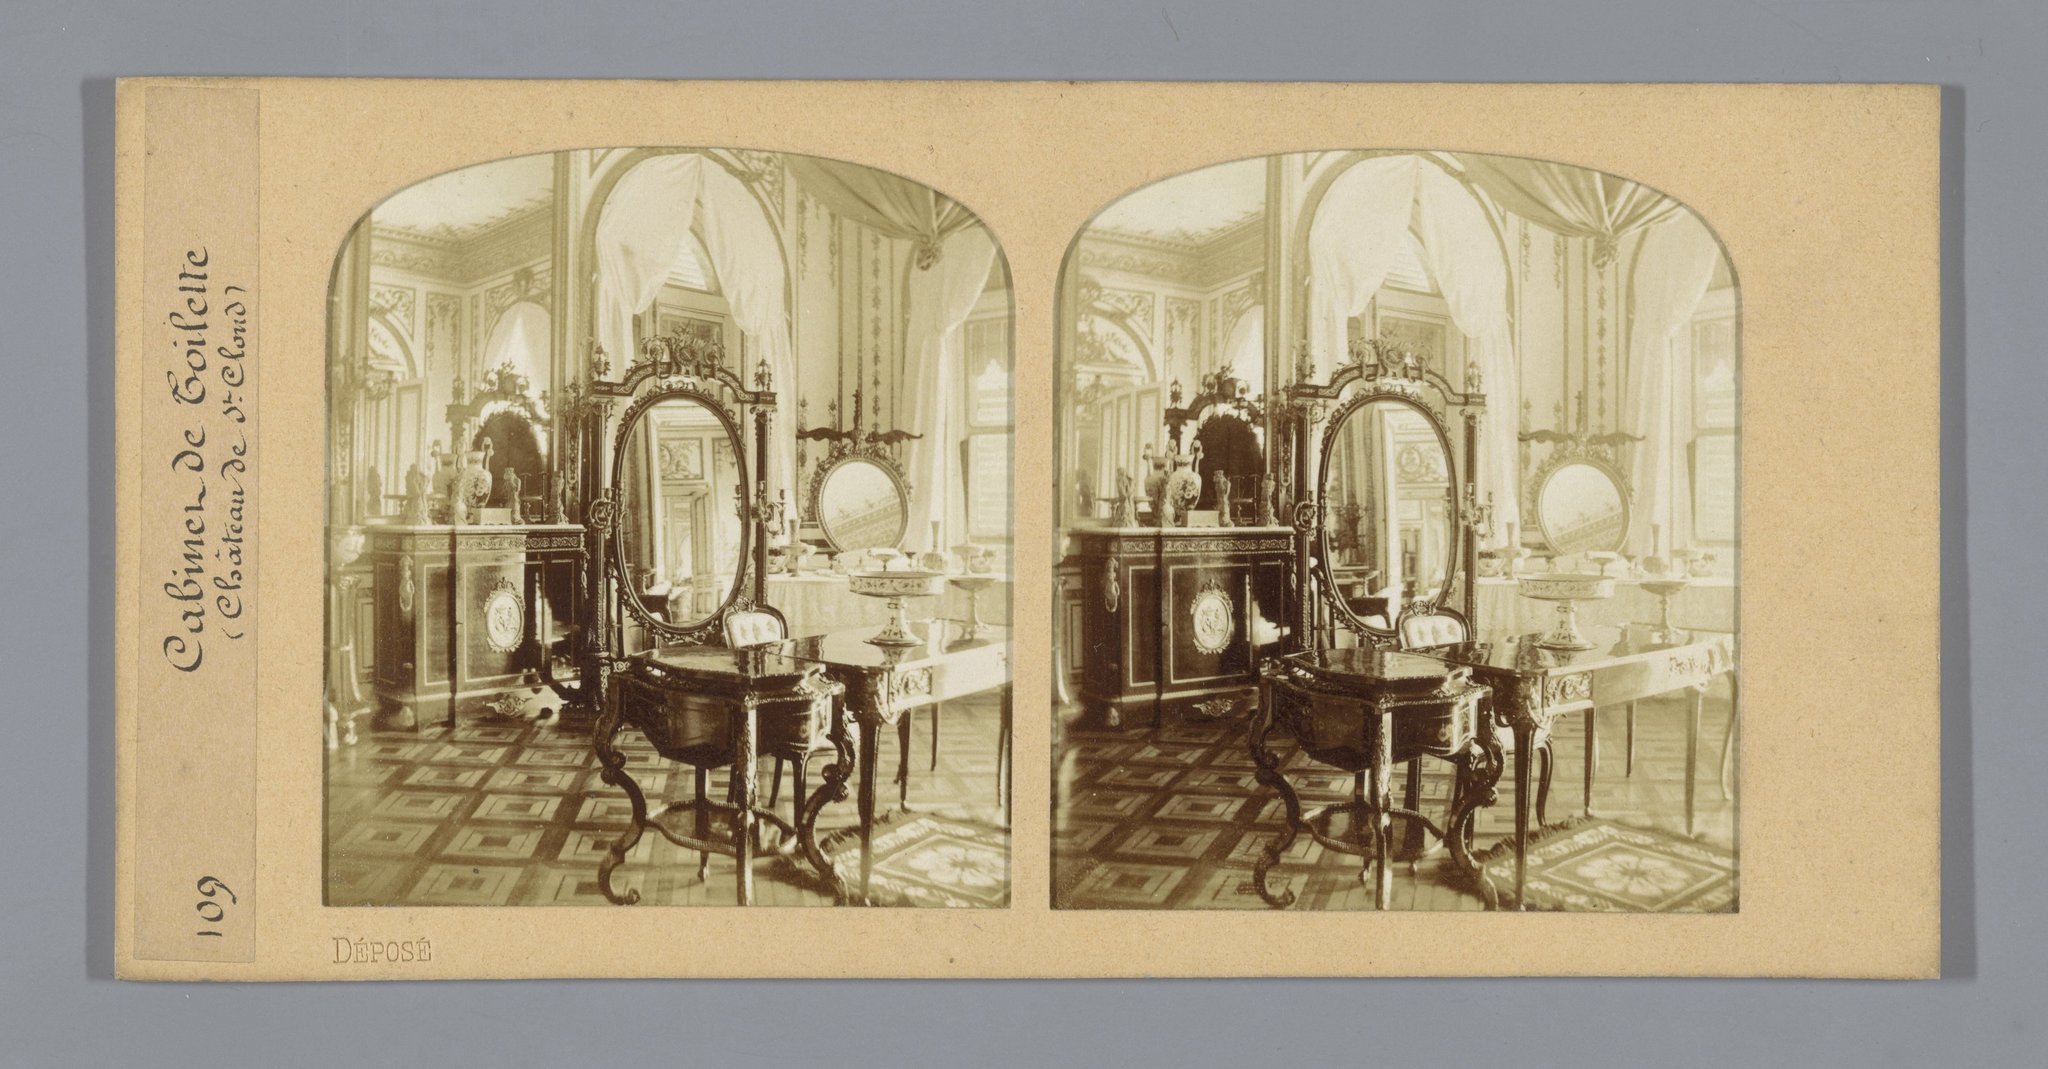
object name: tissue stereograph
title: Kaptafel in het kasteel van Saint-Cloud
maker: florent grau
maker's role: manufacturer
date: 1858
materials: cardboard, paper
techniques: albumen print, hand coloring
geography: saint-cloud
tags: making toilet, mirror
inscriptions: inscription: ‘Déposé’, number: ‘109’